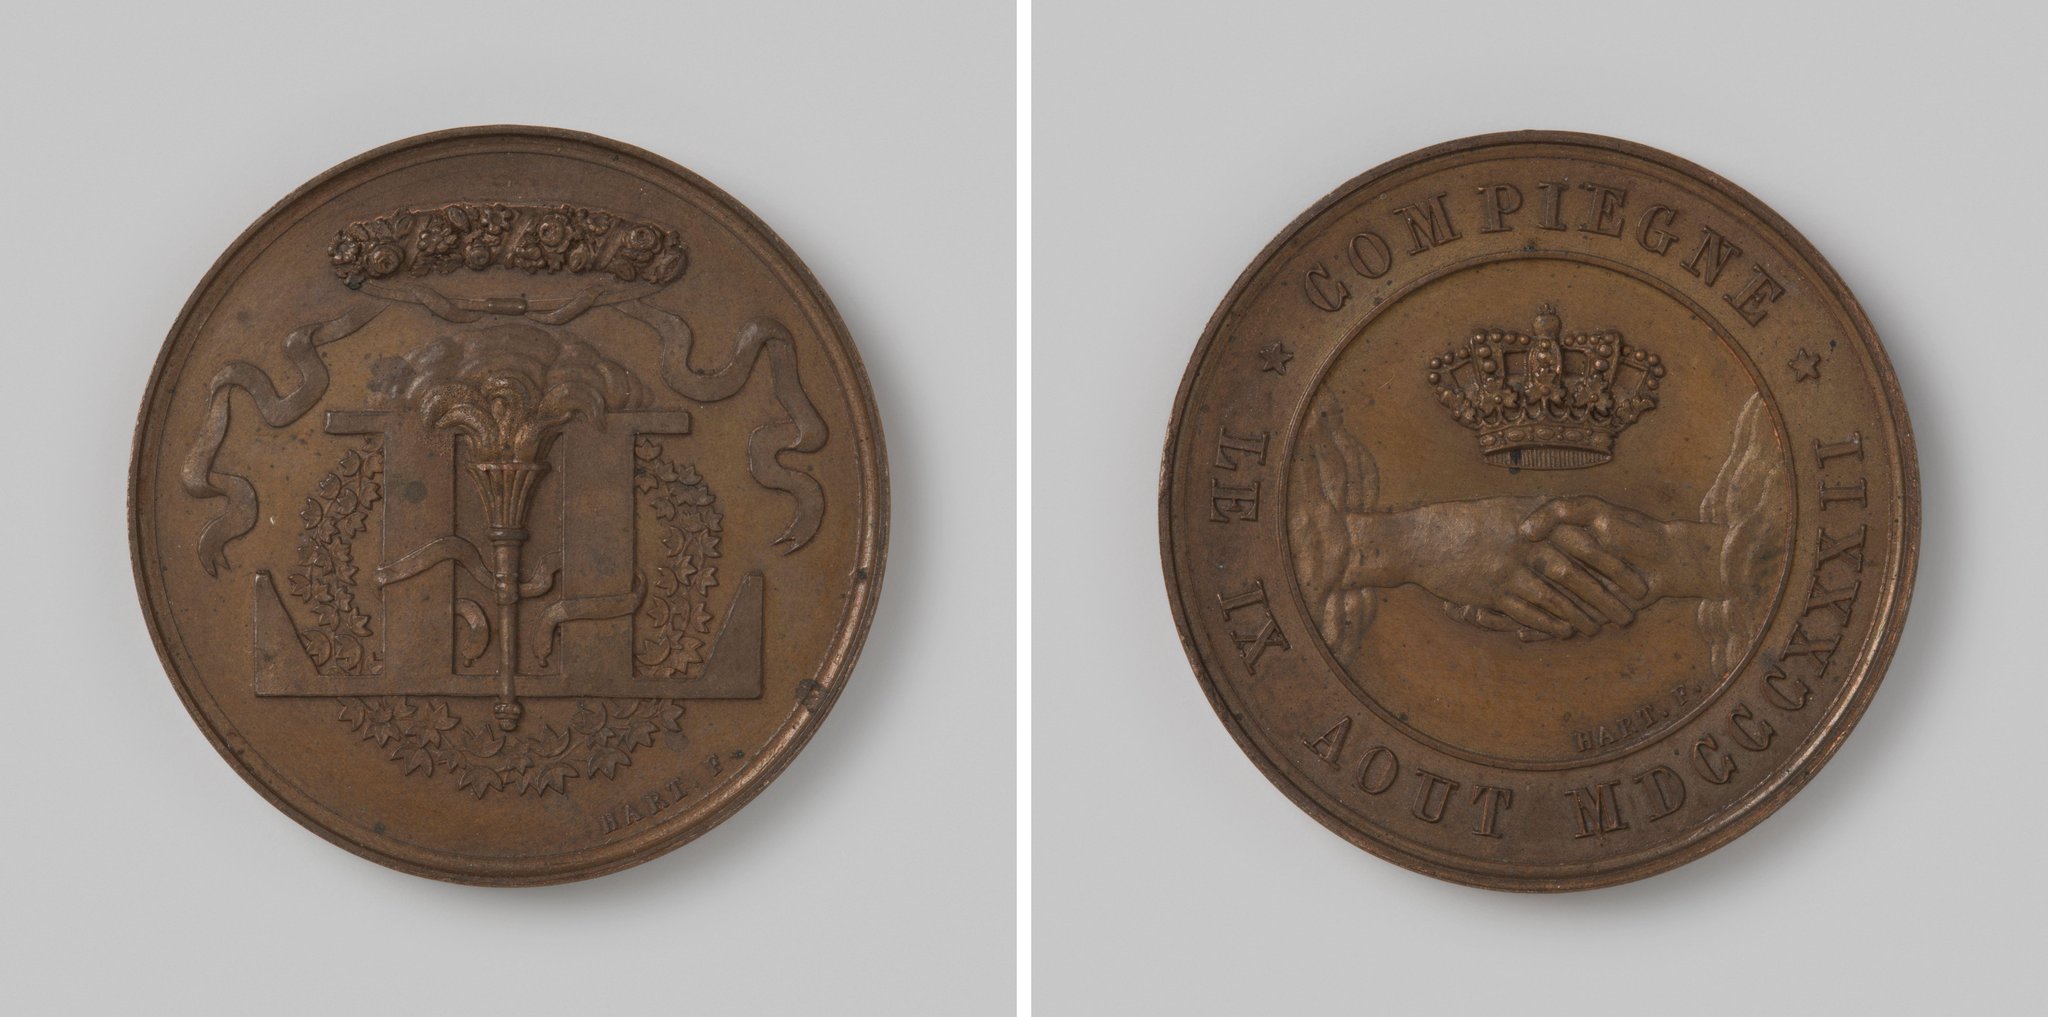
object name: history medal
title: Huwelijk van Leopold I, koning der Belgen en Louise van Orleans te Compiegne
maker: laurent joseph hart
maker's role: die cutter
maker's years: 1810-1860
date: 1832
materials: bronze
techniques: striking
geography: brussels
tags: louise marie van orléans (koningin van belgië), laeken, leopold i (koning der belgen)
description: Bronzen penning. Voorzijde: brandende fakkel tussen twee letters L met lint verbonden en op krans vanklimopblad onder bloemenkrans met linten. Keerzijde: twee ineen geslagen handen uit wolkenonder kroon binnen omschrift